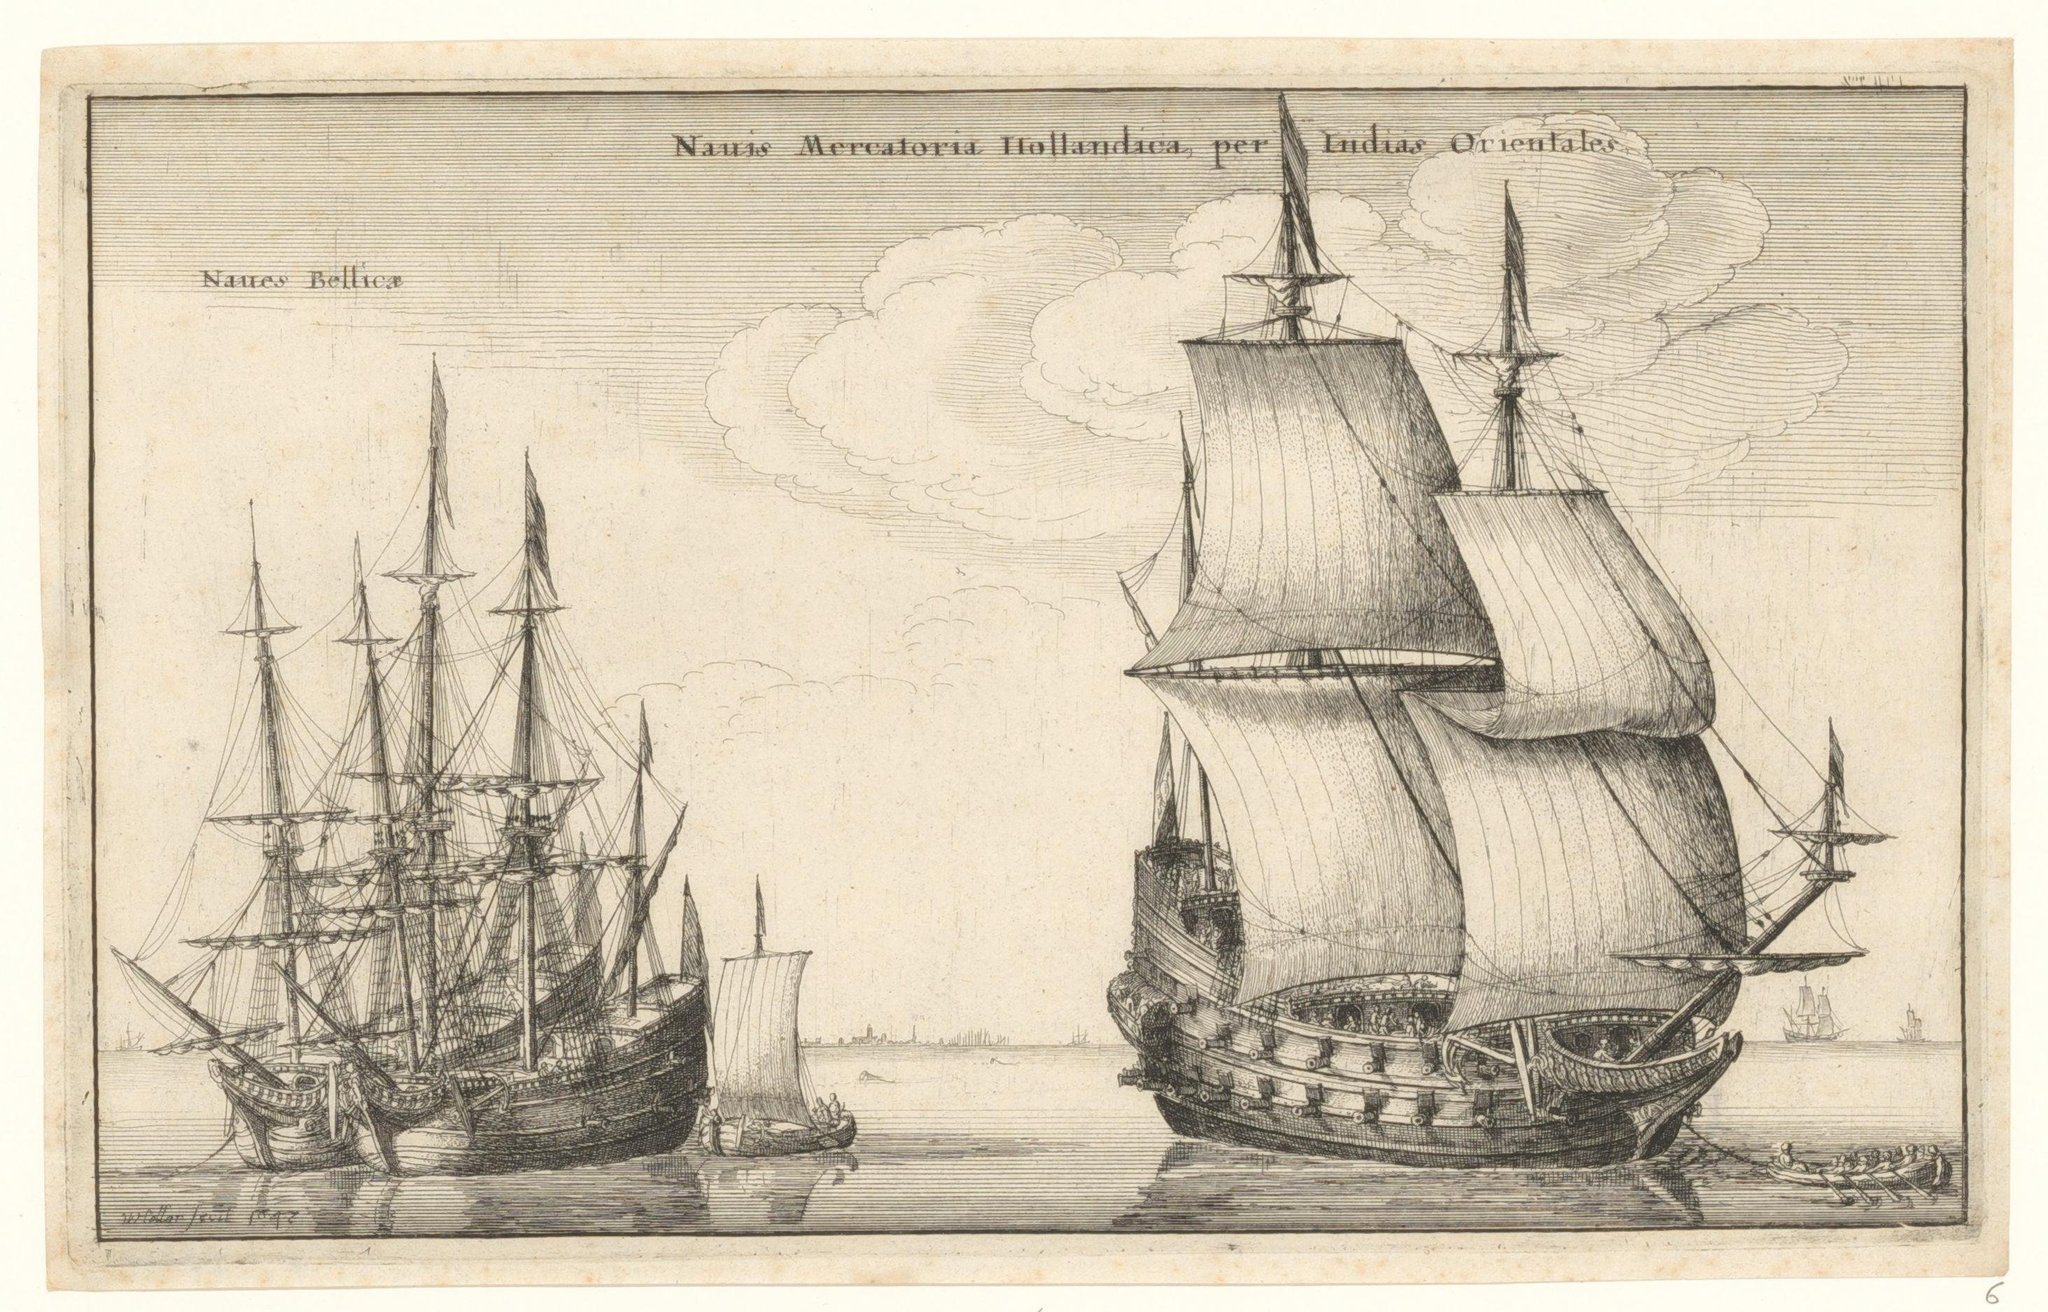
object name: print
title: Verschillende Nederlandse scheepstypen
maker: wenceslaus hollar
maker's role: draughtsman, print maker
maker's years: 1607-1677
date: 1647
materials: paper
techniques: etching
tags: sailing-ship, sailing-boat (westindiaman)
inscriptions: collector's mark: Lugt 1641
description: Onderwerpsrubrieken binnen de Atlas Zeden en Gewoonten: Handel, Nijverheid en Verkeer, Scheepsbouw.